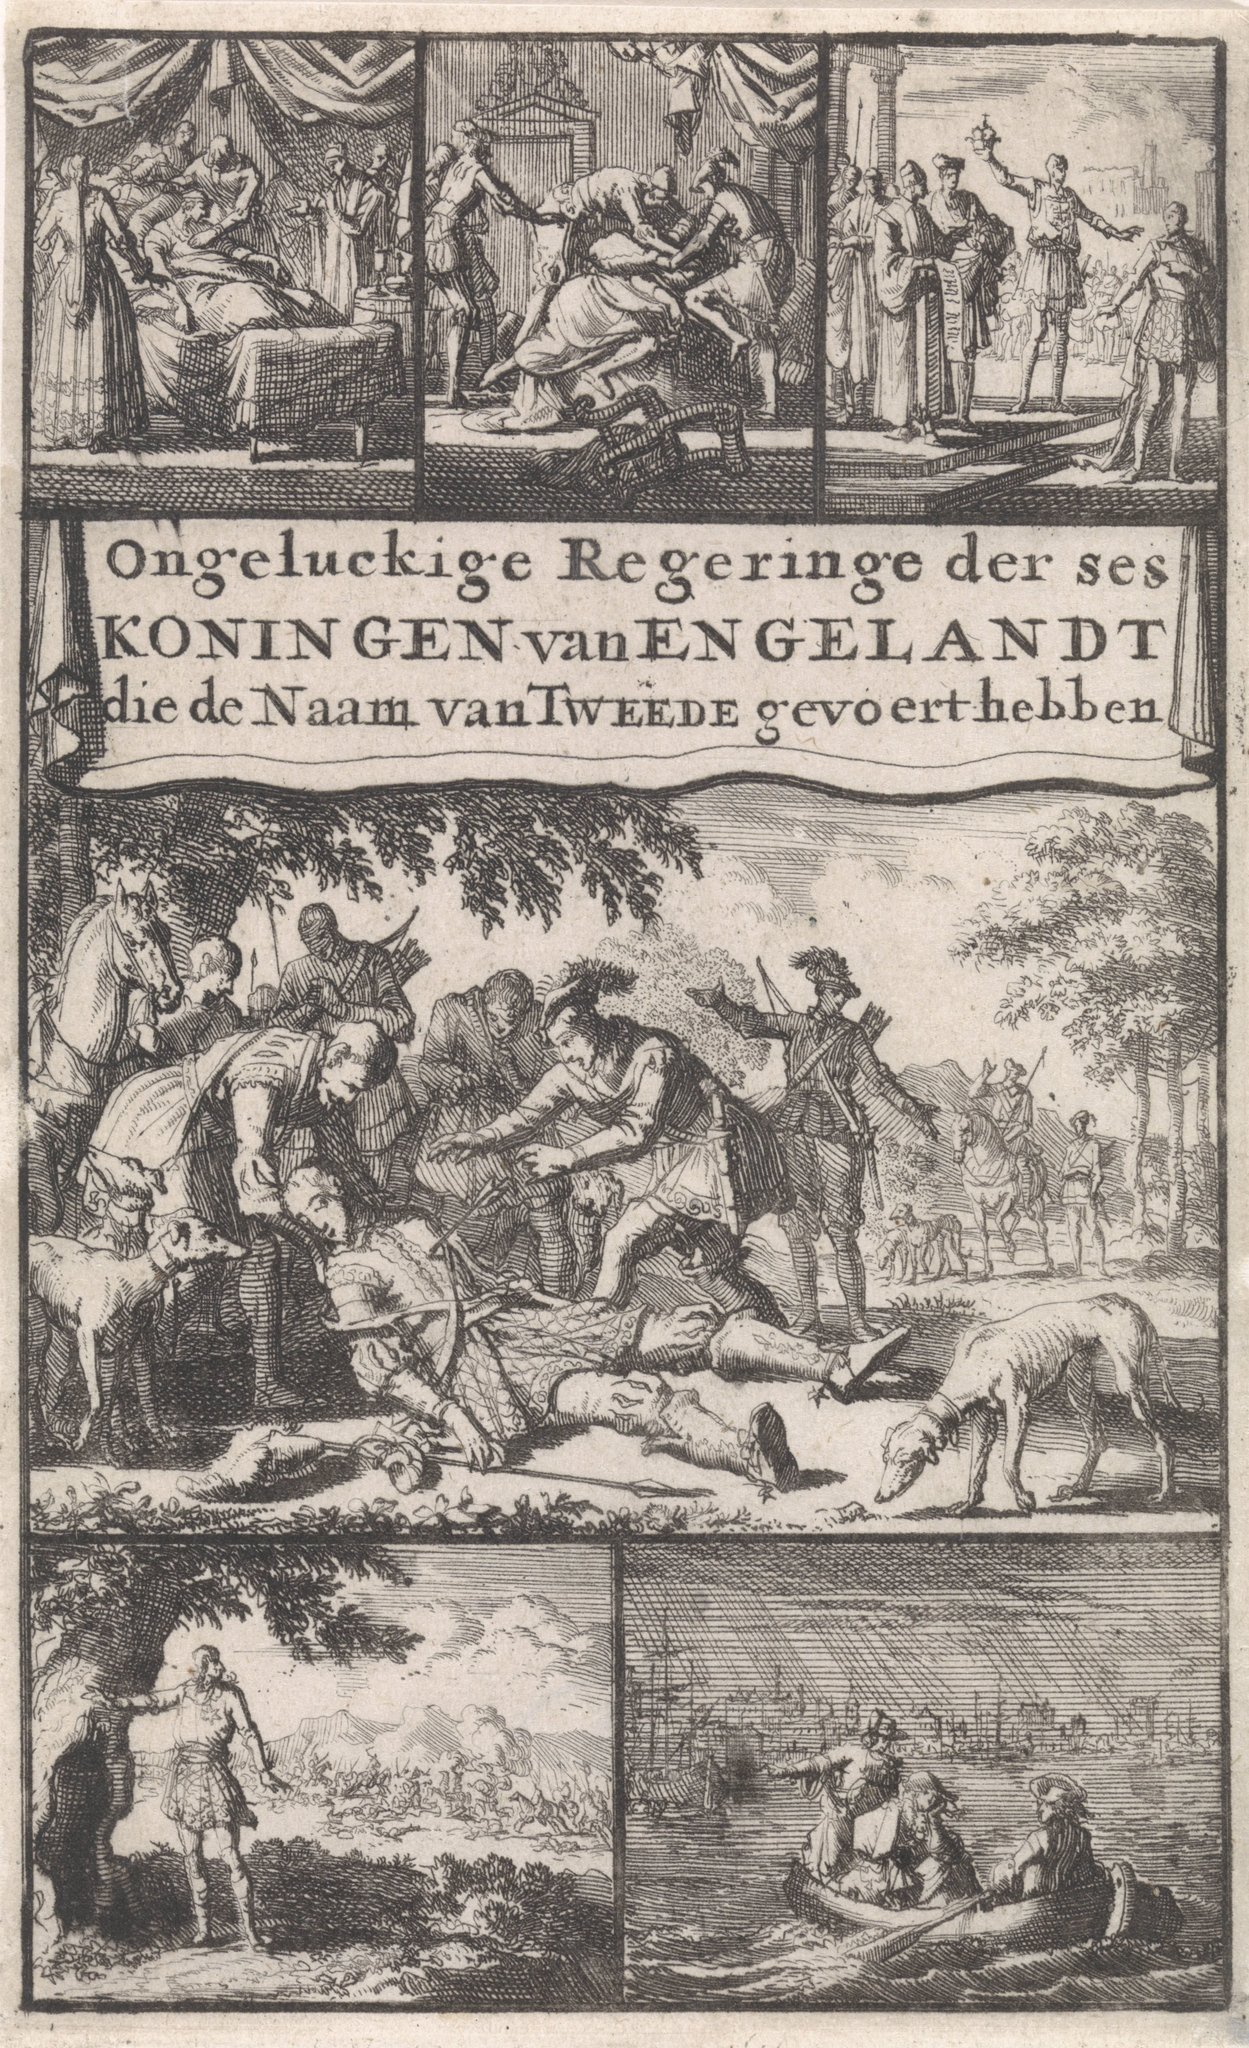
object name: titelblad, titelpagina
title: Titelpagina voor: C. Caesar, Vertoog van de ongelukkige regeringe en het rampzalig leven der zes Engelsche koningen die voorheen den naam van de Tweede gevoert hebben, 1696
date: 1696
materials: paper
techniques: etching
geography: amsterdam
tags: jacobus ii (koning van engeland en schotland), london, karel ii (koning van engeland), hunting, chase, violent death by arrow(s)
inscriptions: collector's mark: Lugt 2228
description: Titelpagina voor: Caesar, Charles. Vertoog van de ongelukkige regeringe en het rampzalig leven der zes Engelsche koningen die voorheen den naam van de Tweede gevoert hebben. Amsterdam: Jan Claesz ten Hoorn, 1696.